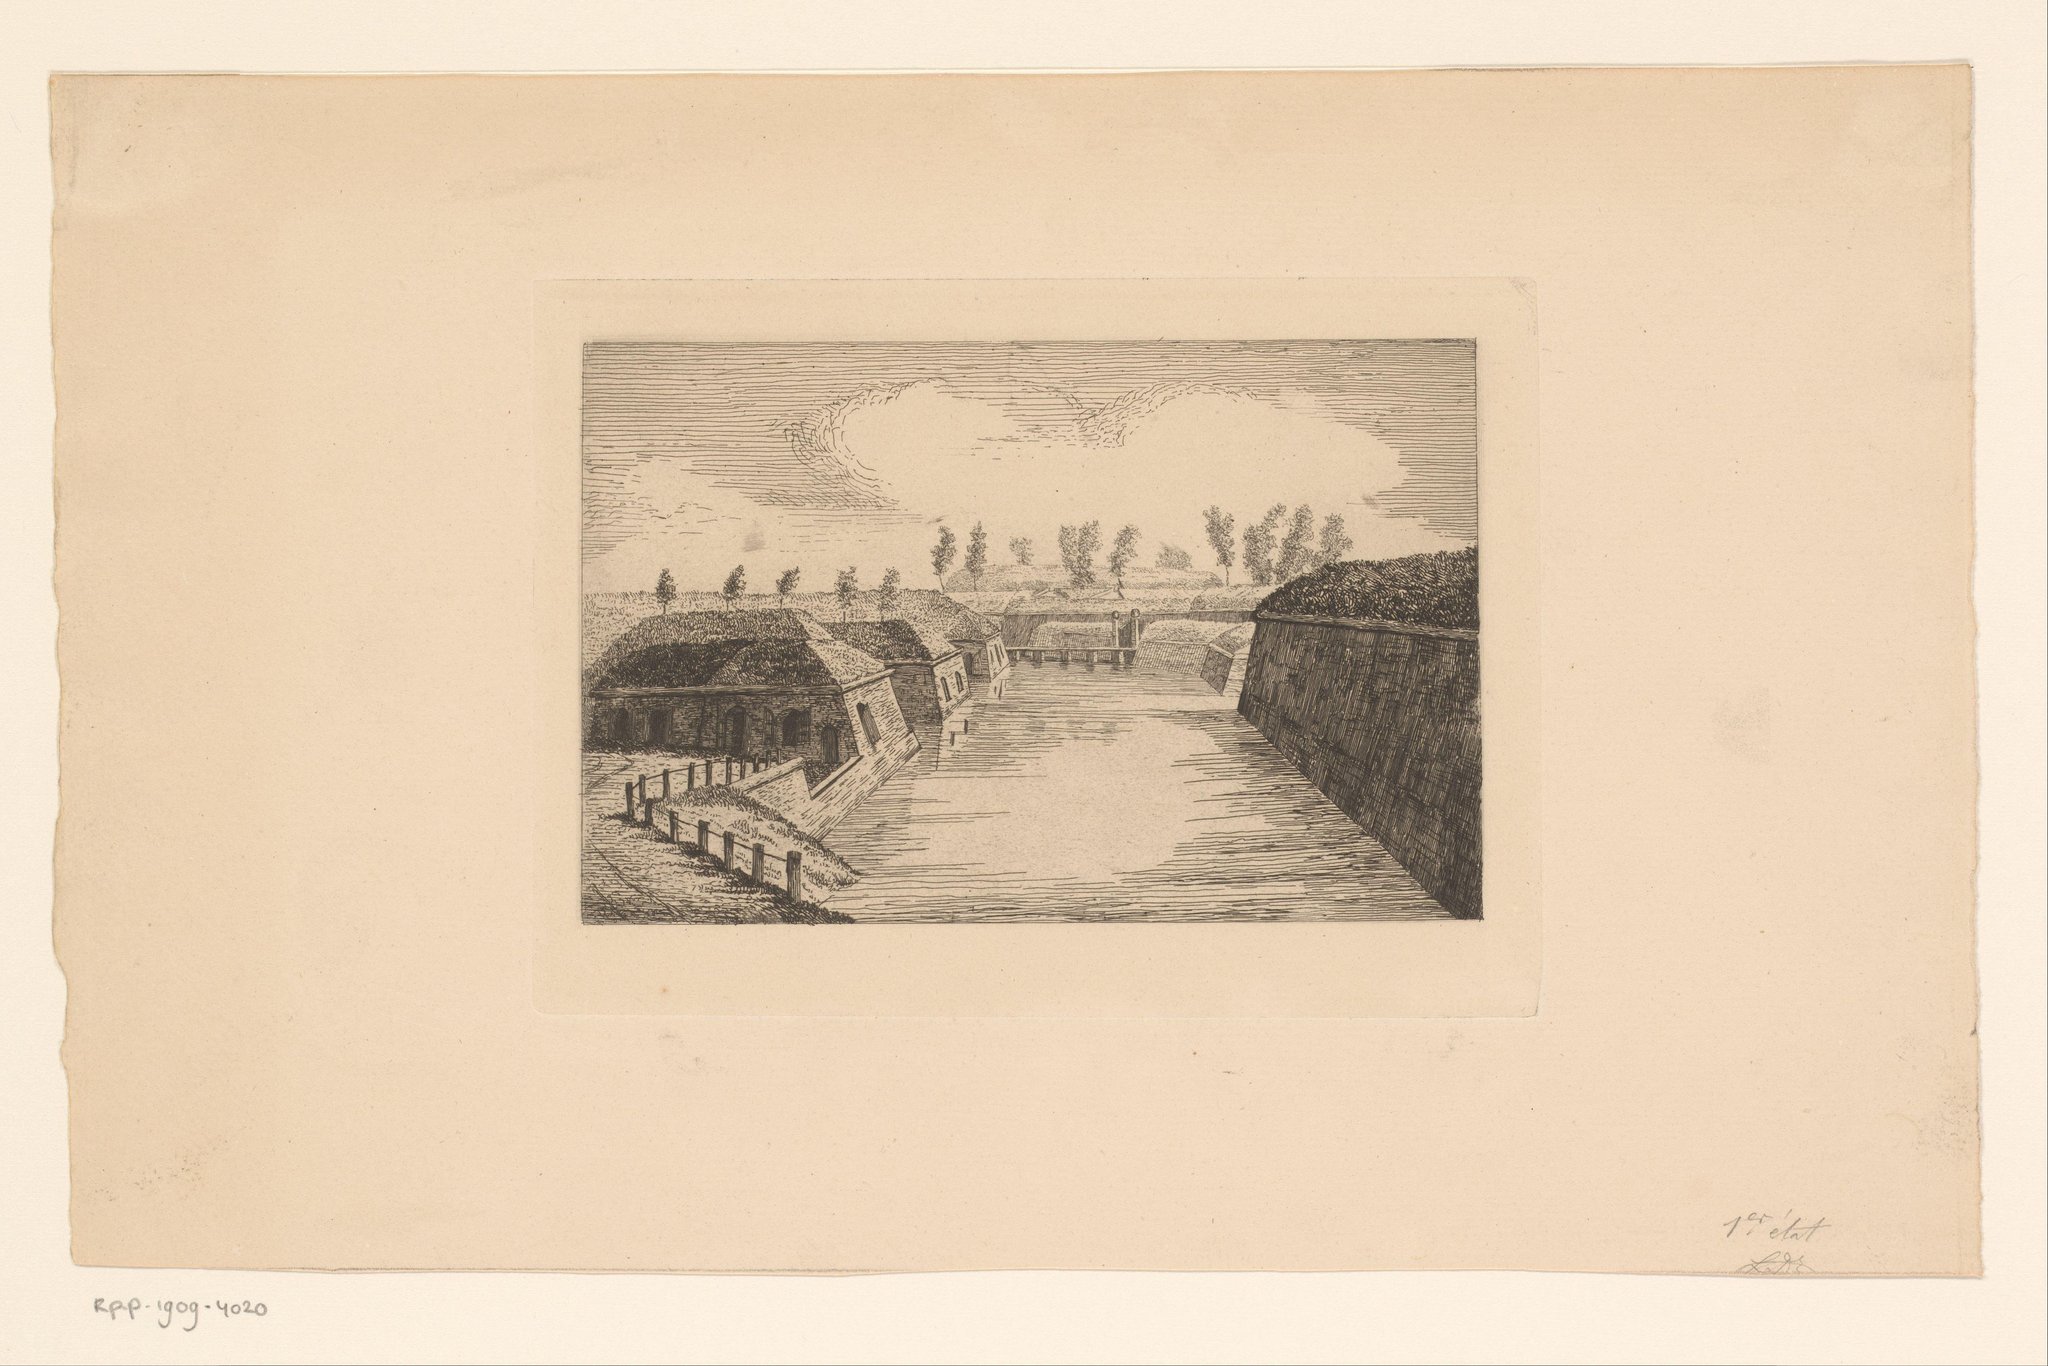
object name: print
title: Kanaal bij de poort van Nimy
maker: léon dolez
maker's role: print maker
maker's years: 1837-1902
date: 1875-1878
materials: paper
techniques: drypoint, etching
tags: canal, city-gate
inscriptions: collector's mark: Lugt 2228